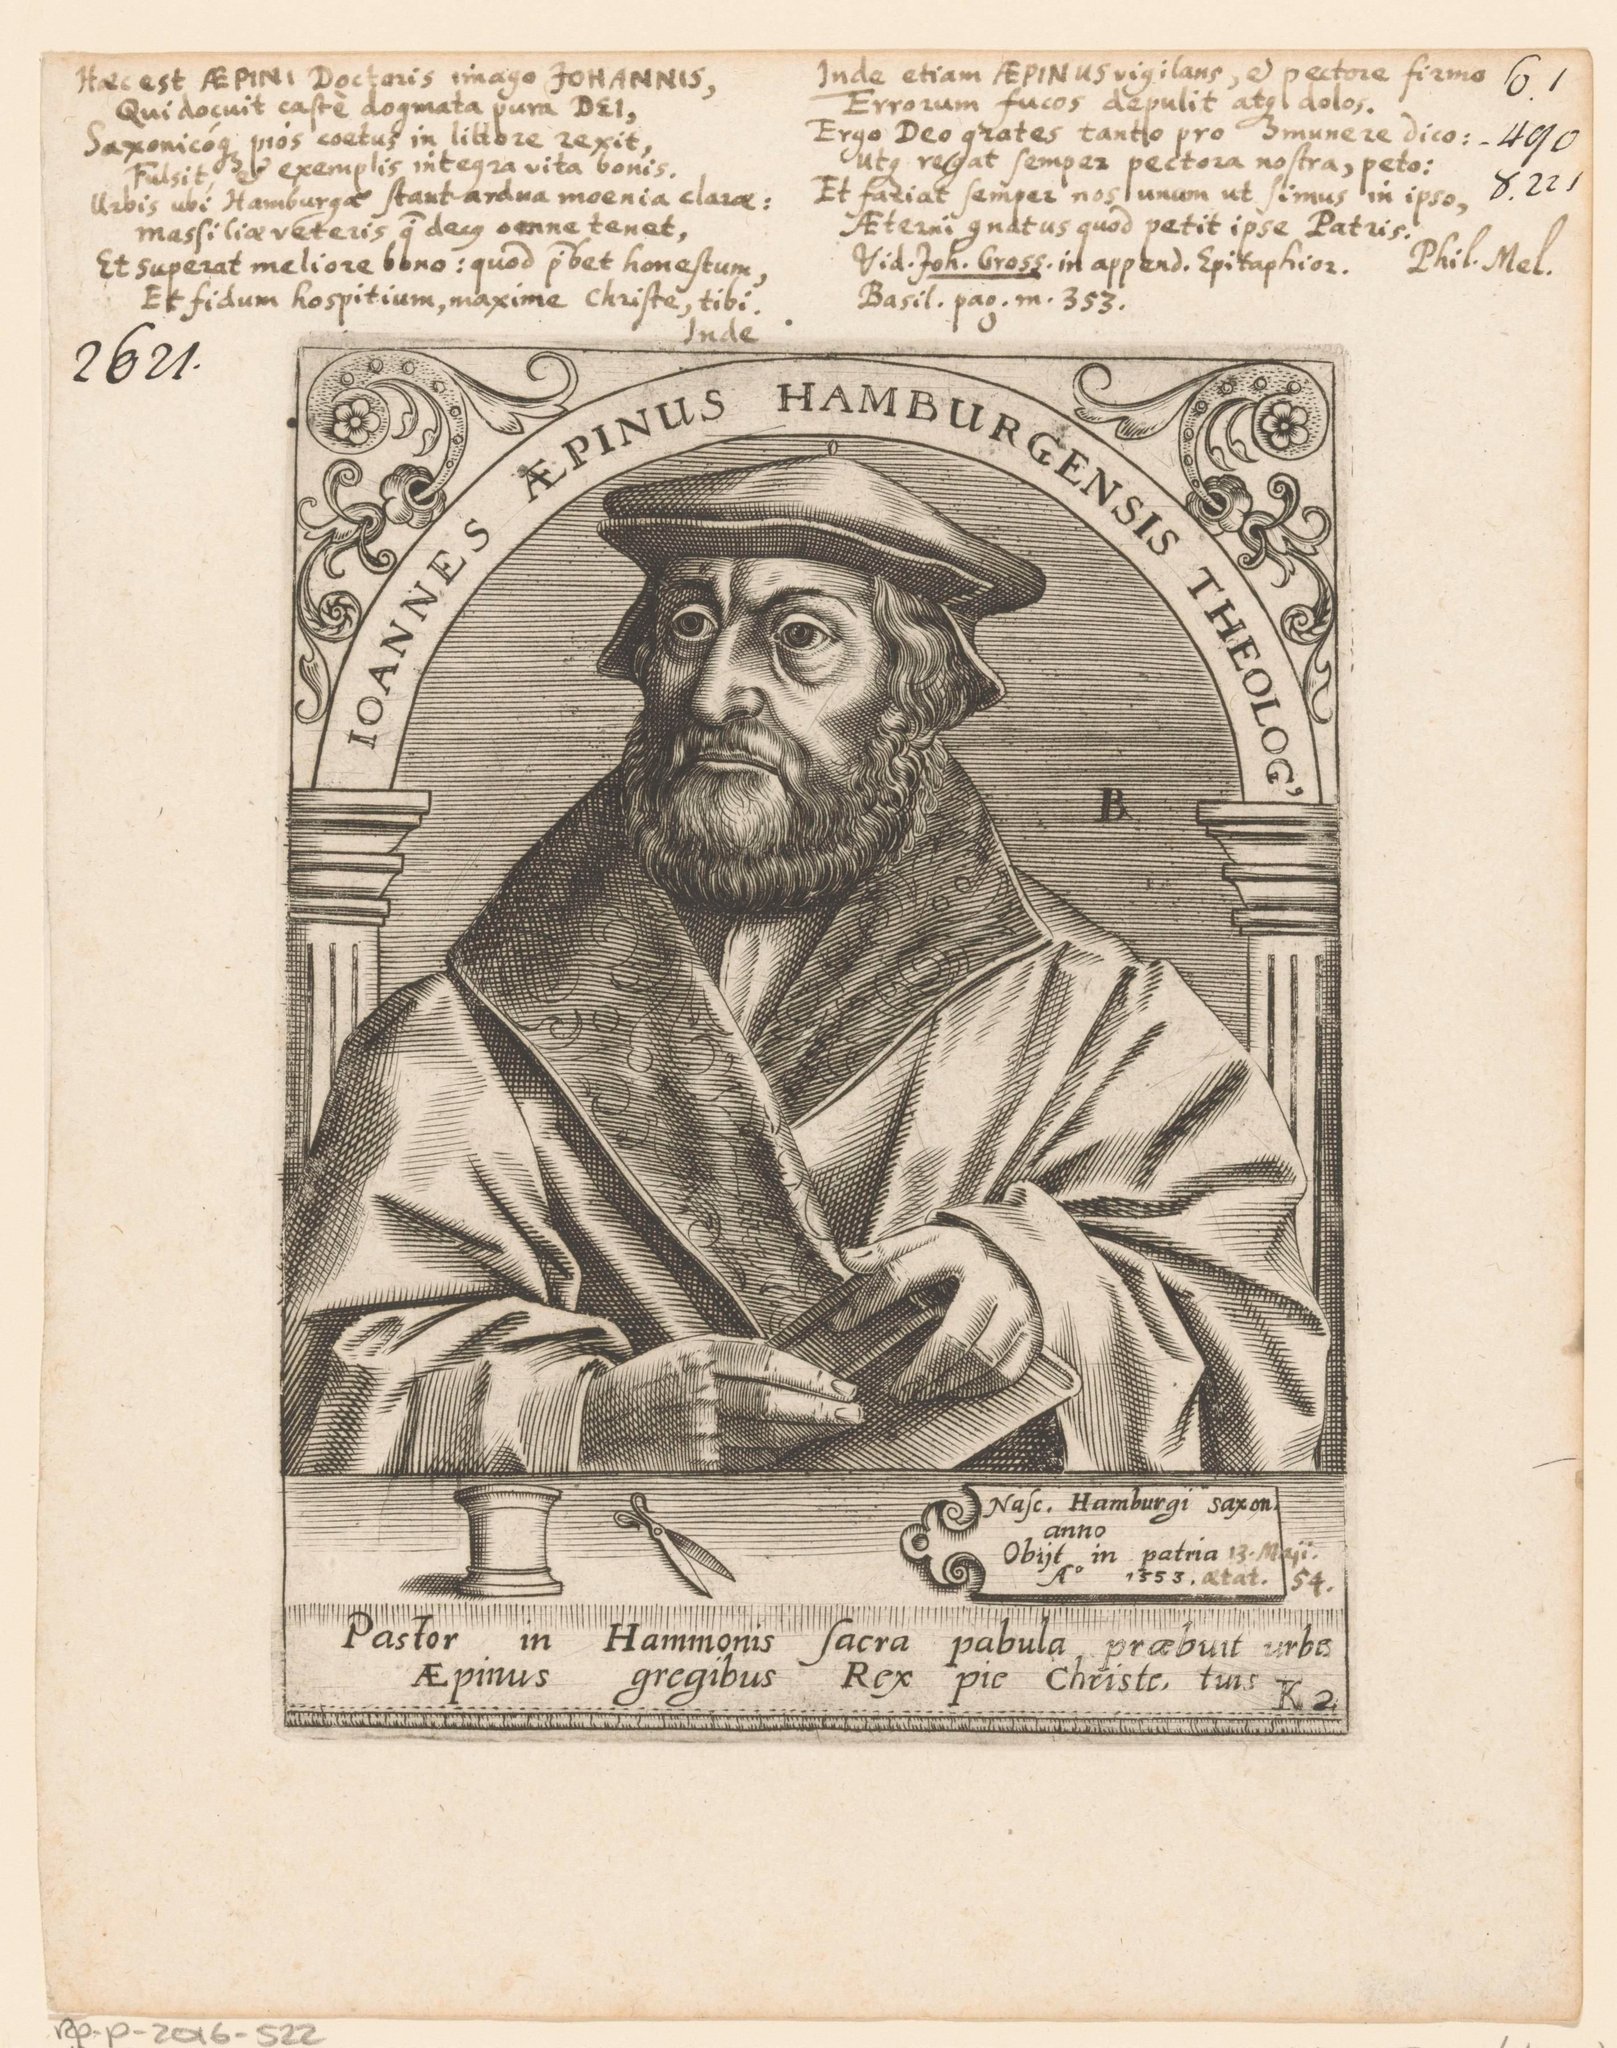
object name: print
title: Portret van Johannes Aepinus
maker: robert boissard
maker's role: print maker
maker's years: 1570-1611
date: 1580-1611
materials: paper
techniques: engraving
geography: alsace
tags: johannes aepinus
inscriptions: inscription: ‘Haec est (...) Basil. pag. nr. 353.’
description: Portret van Johannes Aepinus onder een boog met randschrift. Hij heeft een boek in zijn handen. Op de voorgrond ligt een aantal objecten. In een kader zijn geboorteplaats, zijn sterfplaats en zijn sterfjaar. In de ondermarge twee regels Latijnse tekst. Rechtsonder: K 2.